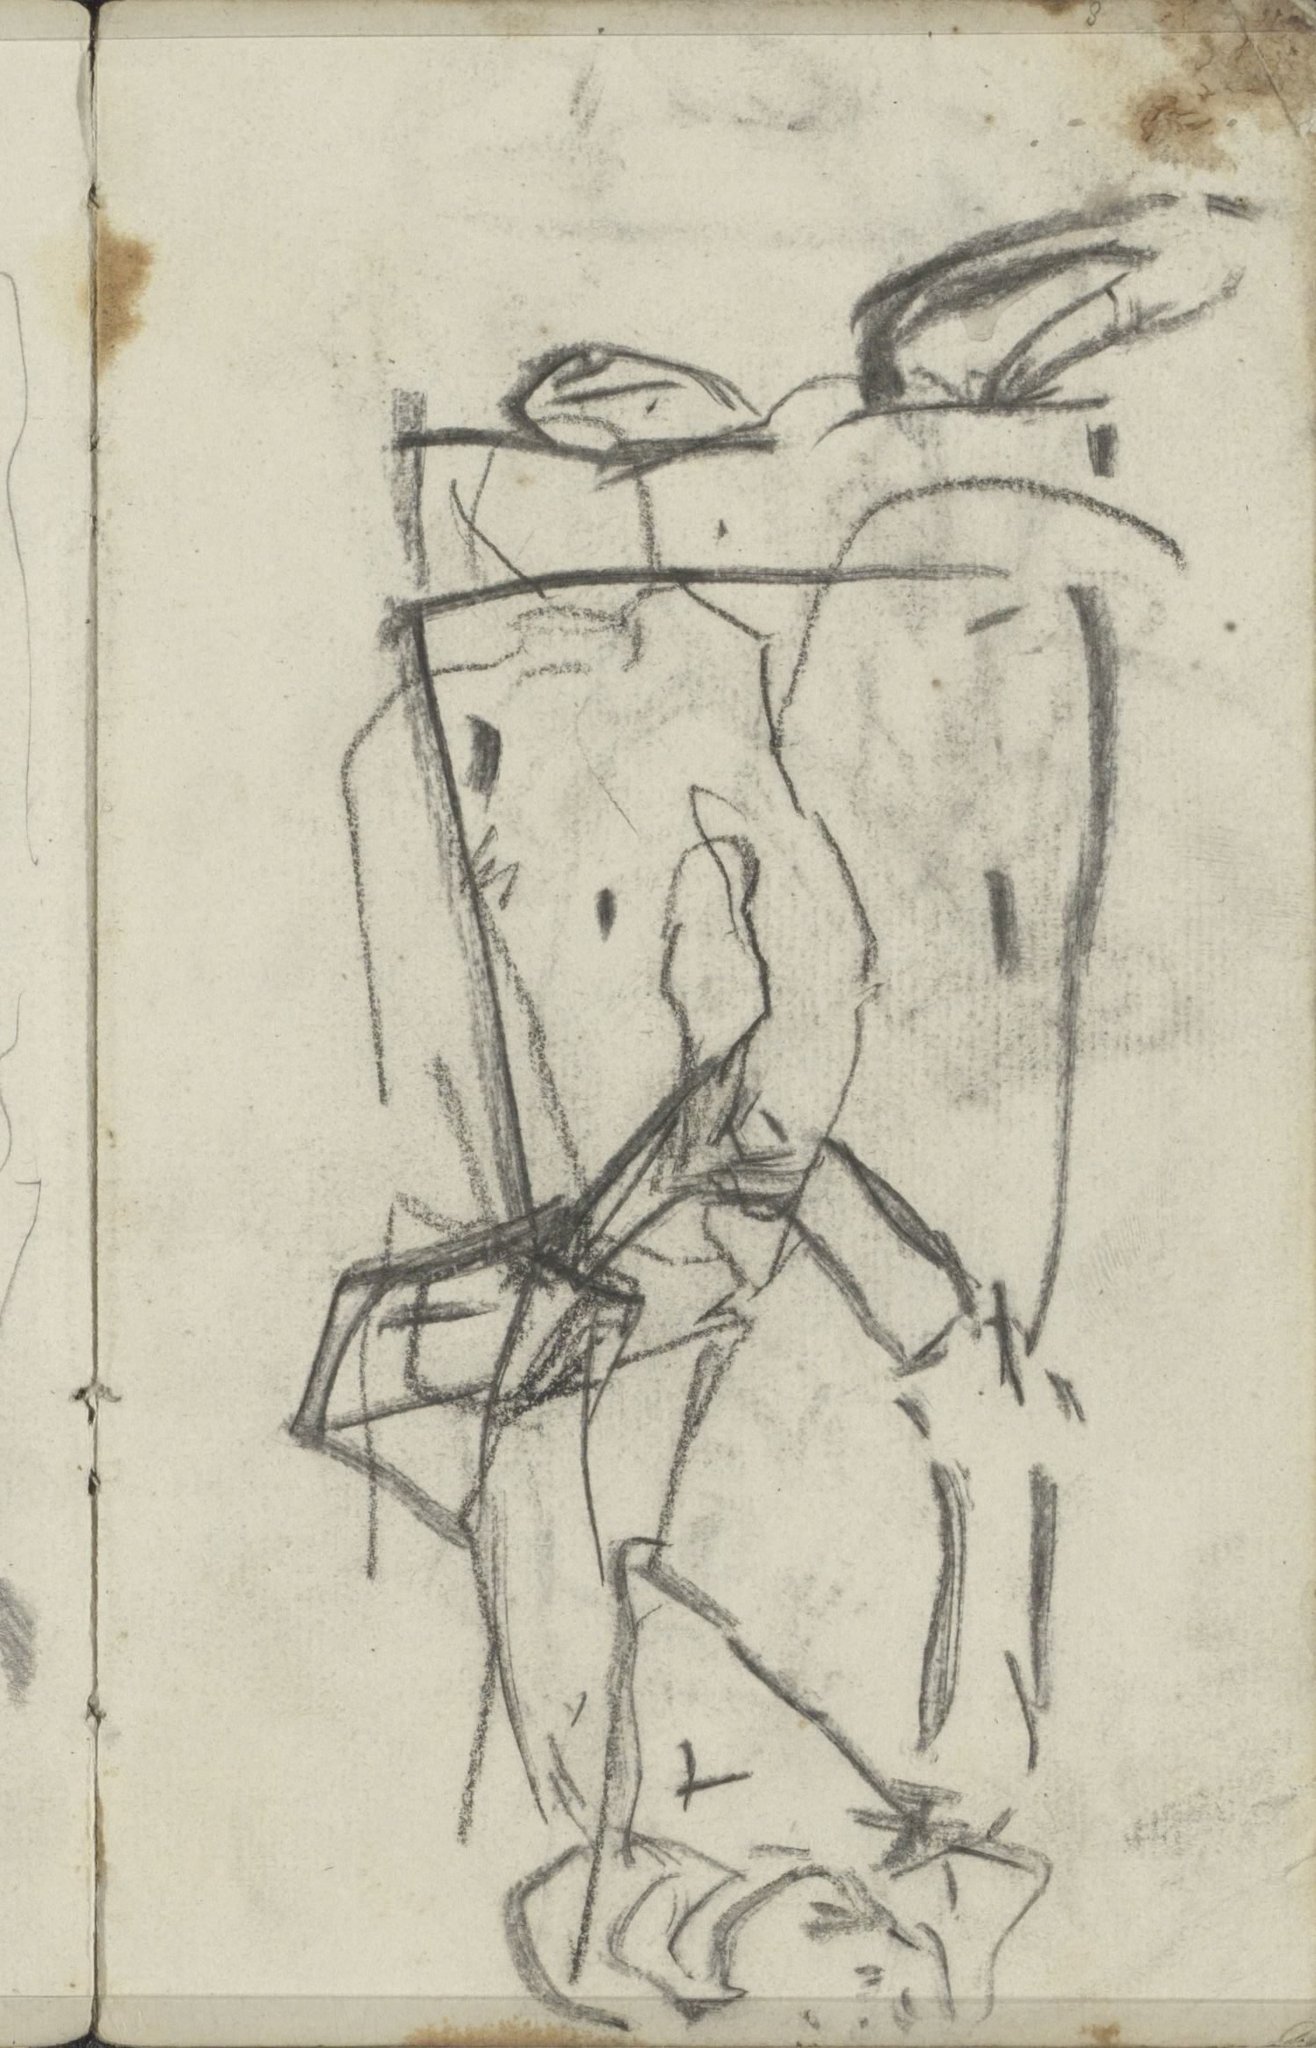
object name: sketchbook leaf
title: Vrouw met een voorwerp in haar handen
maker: george hendrik breitner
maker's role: draughtsman, painter, print maker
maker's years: 1857-1923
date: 1883-1885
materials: chalk, paper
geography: the hague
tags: adult woman, carrying something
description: Pagina 8 uit een schetsboek met 17 bladen.